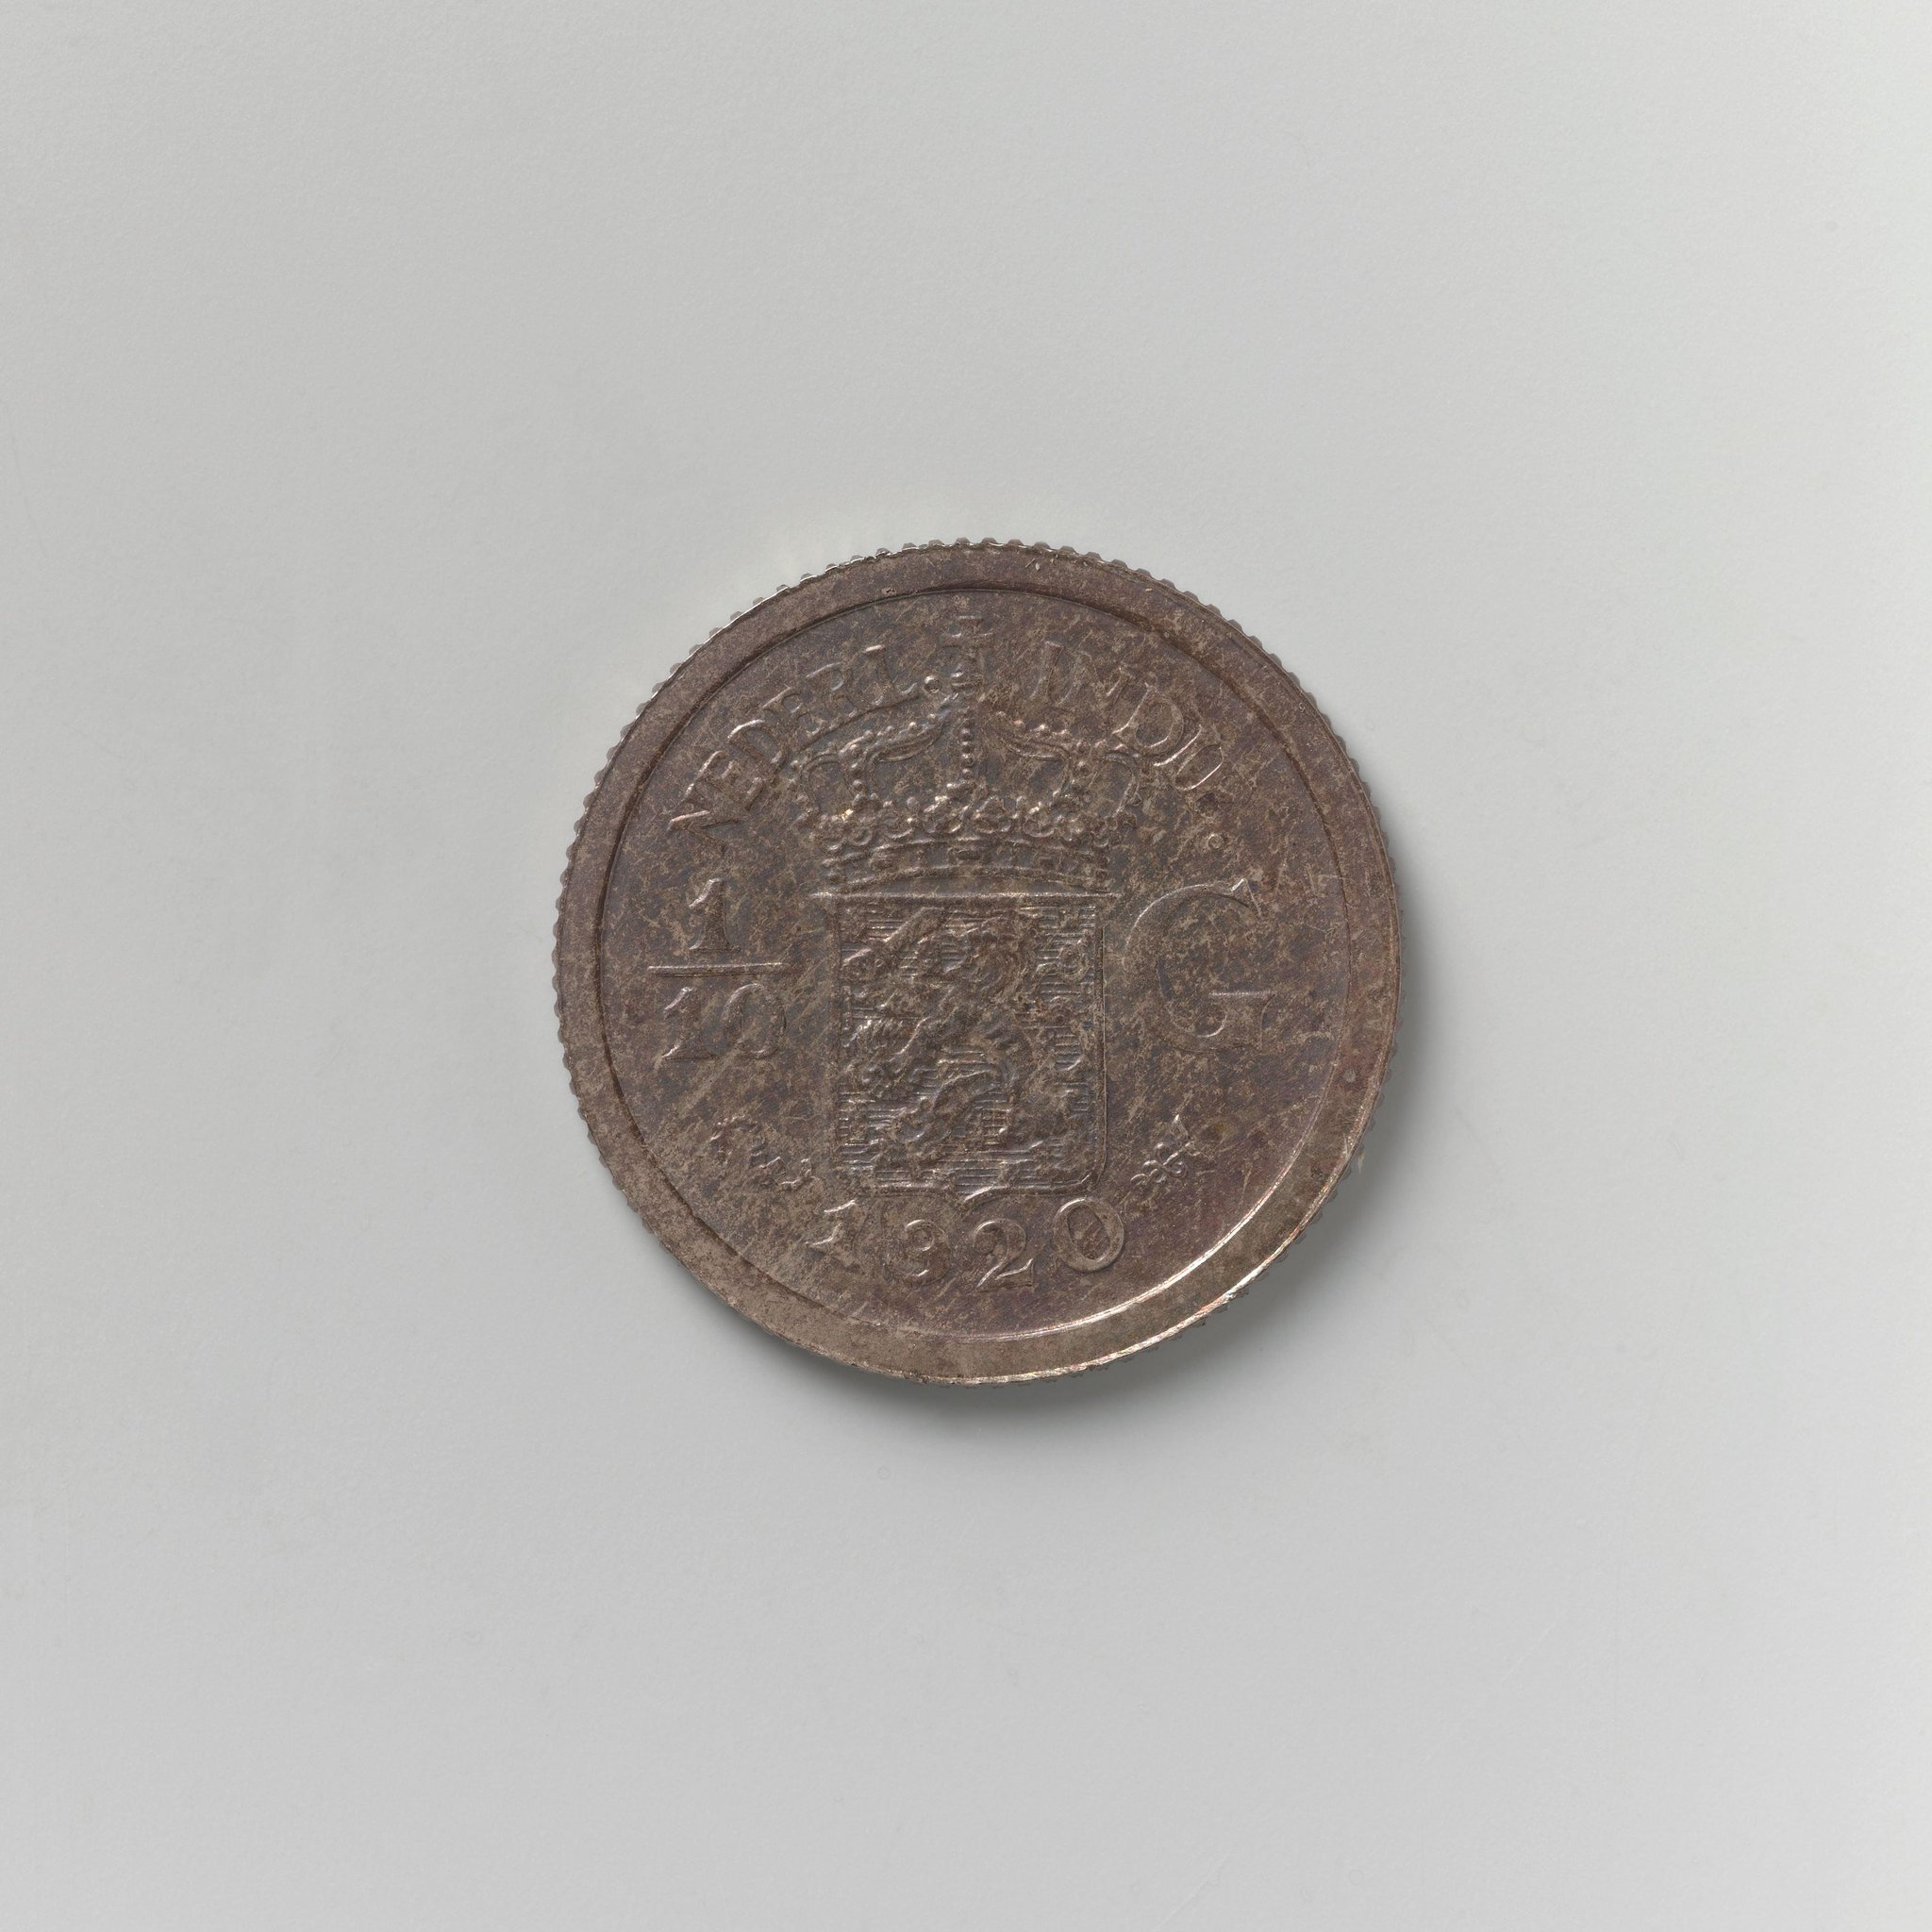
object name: coin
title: 1/10 gulden van Nederlands Indië,1920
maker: wilhelmina of the netherlands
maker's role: print maker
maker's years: 1880-1962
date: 1920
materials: copper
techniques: striking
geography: utrecht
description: Zilveren munt. Voorzijde: tussen waarde-aanduiding 1/10 G gekroond rijkswapenschild. Boven kroon landsaanduiding en onder wapenschild jaartal. Keerzijde: tweeregelig Maleis opschrift in Arabische tekens, waaromheen omschrift in het Javaans. Kartelrand.